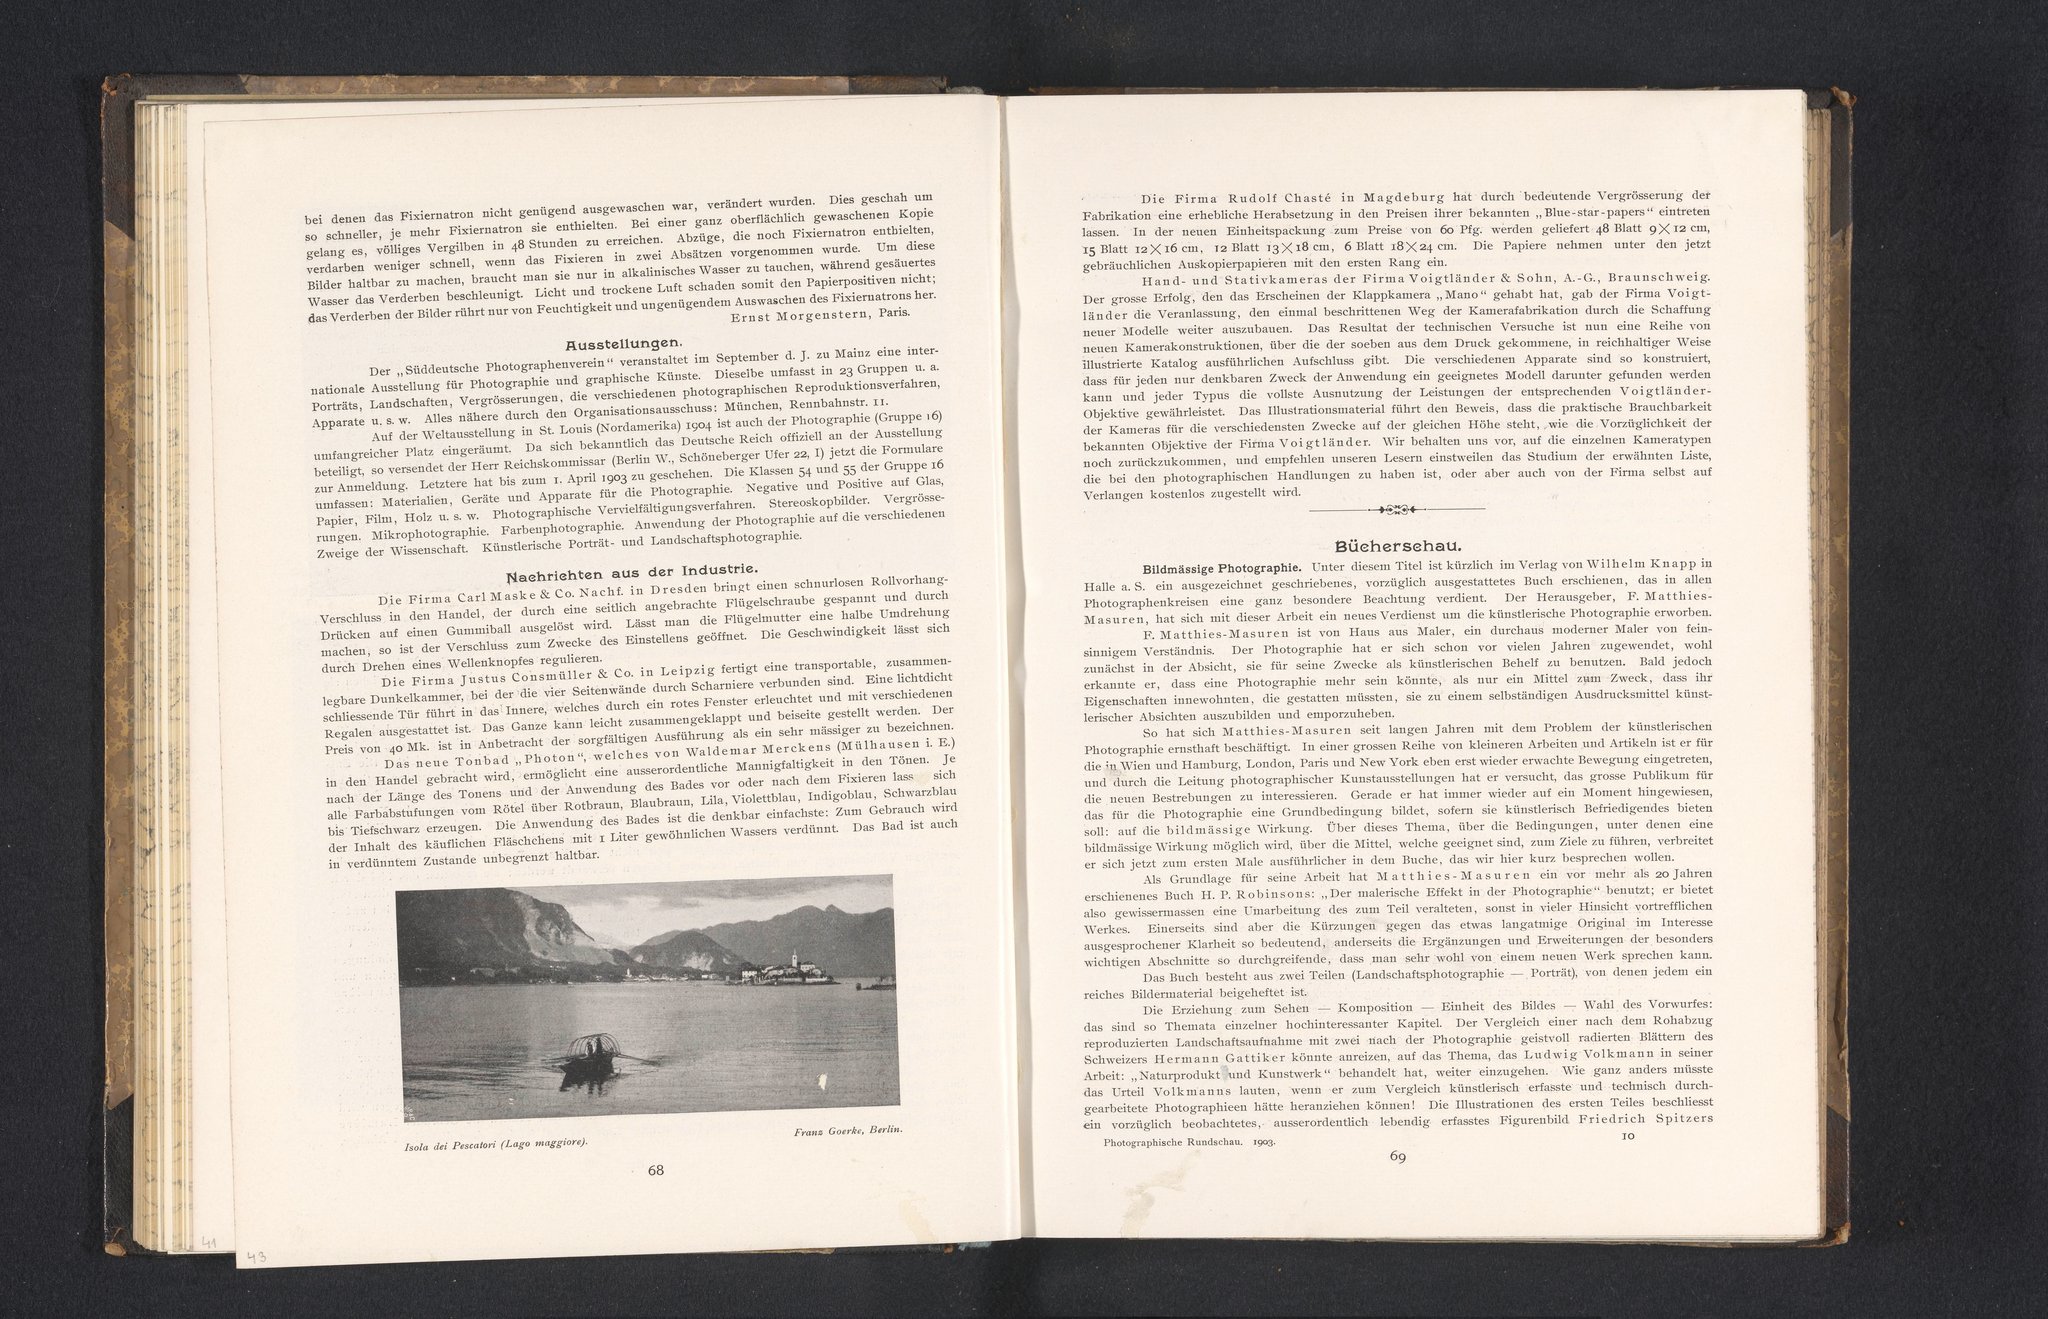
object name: page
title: Isola dei Pescatori (Lago maggiore)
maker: franz goerke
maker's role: fotograaf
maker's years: 1856-1931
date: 1898-1903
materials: paper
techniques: autotype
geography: berlin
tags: island, rowing-boat, canoe, etc.